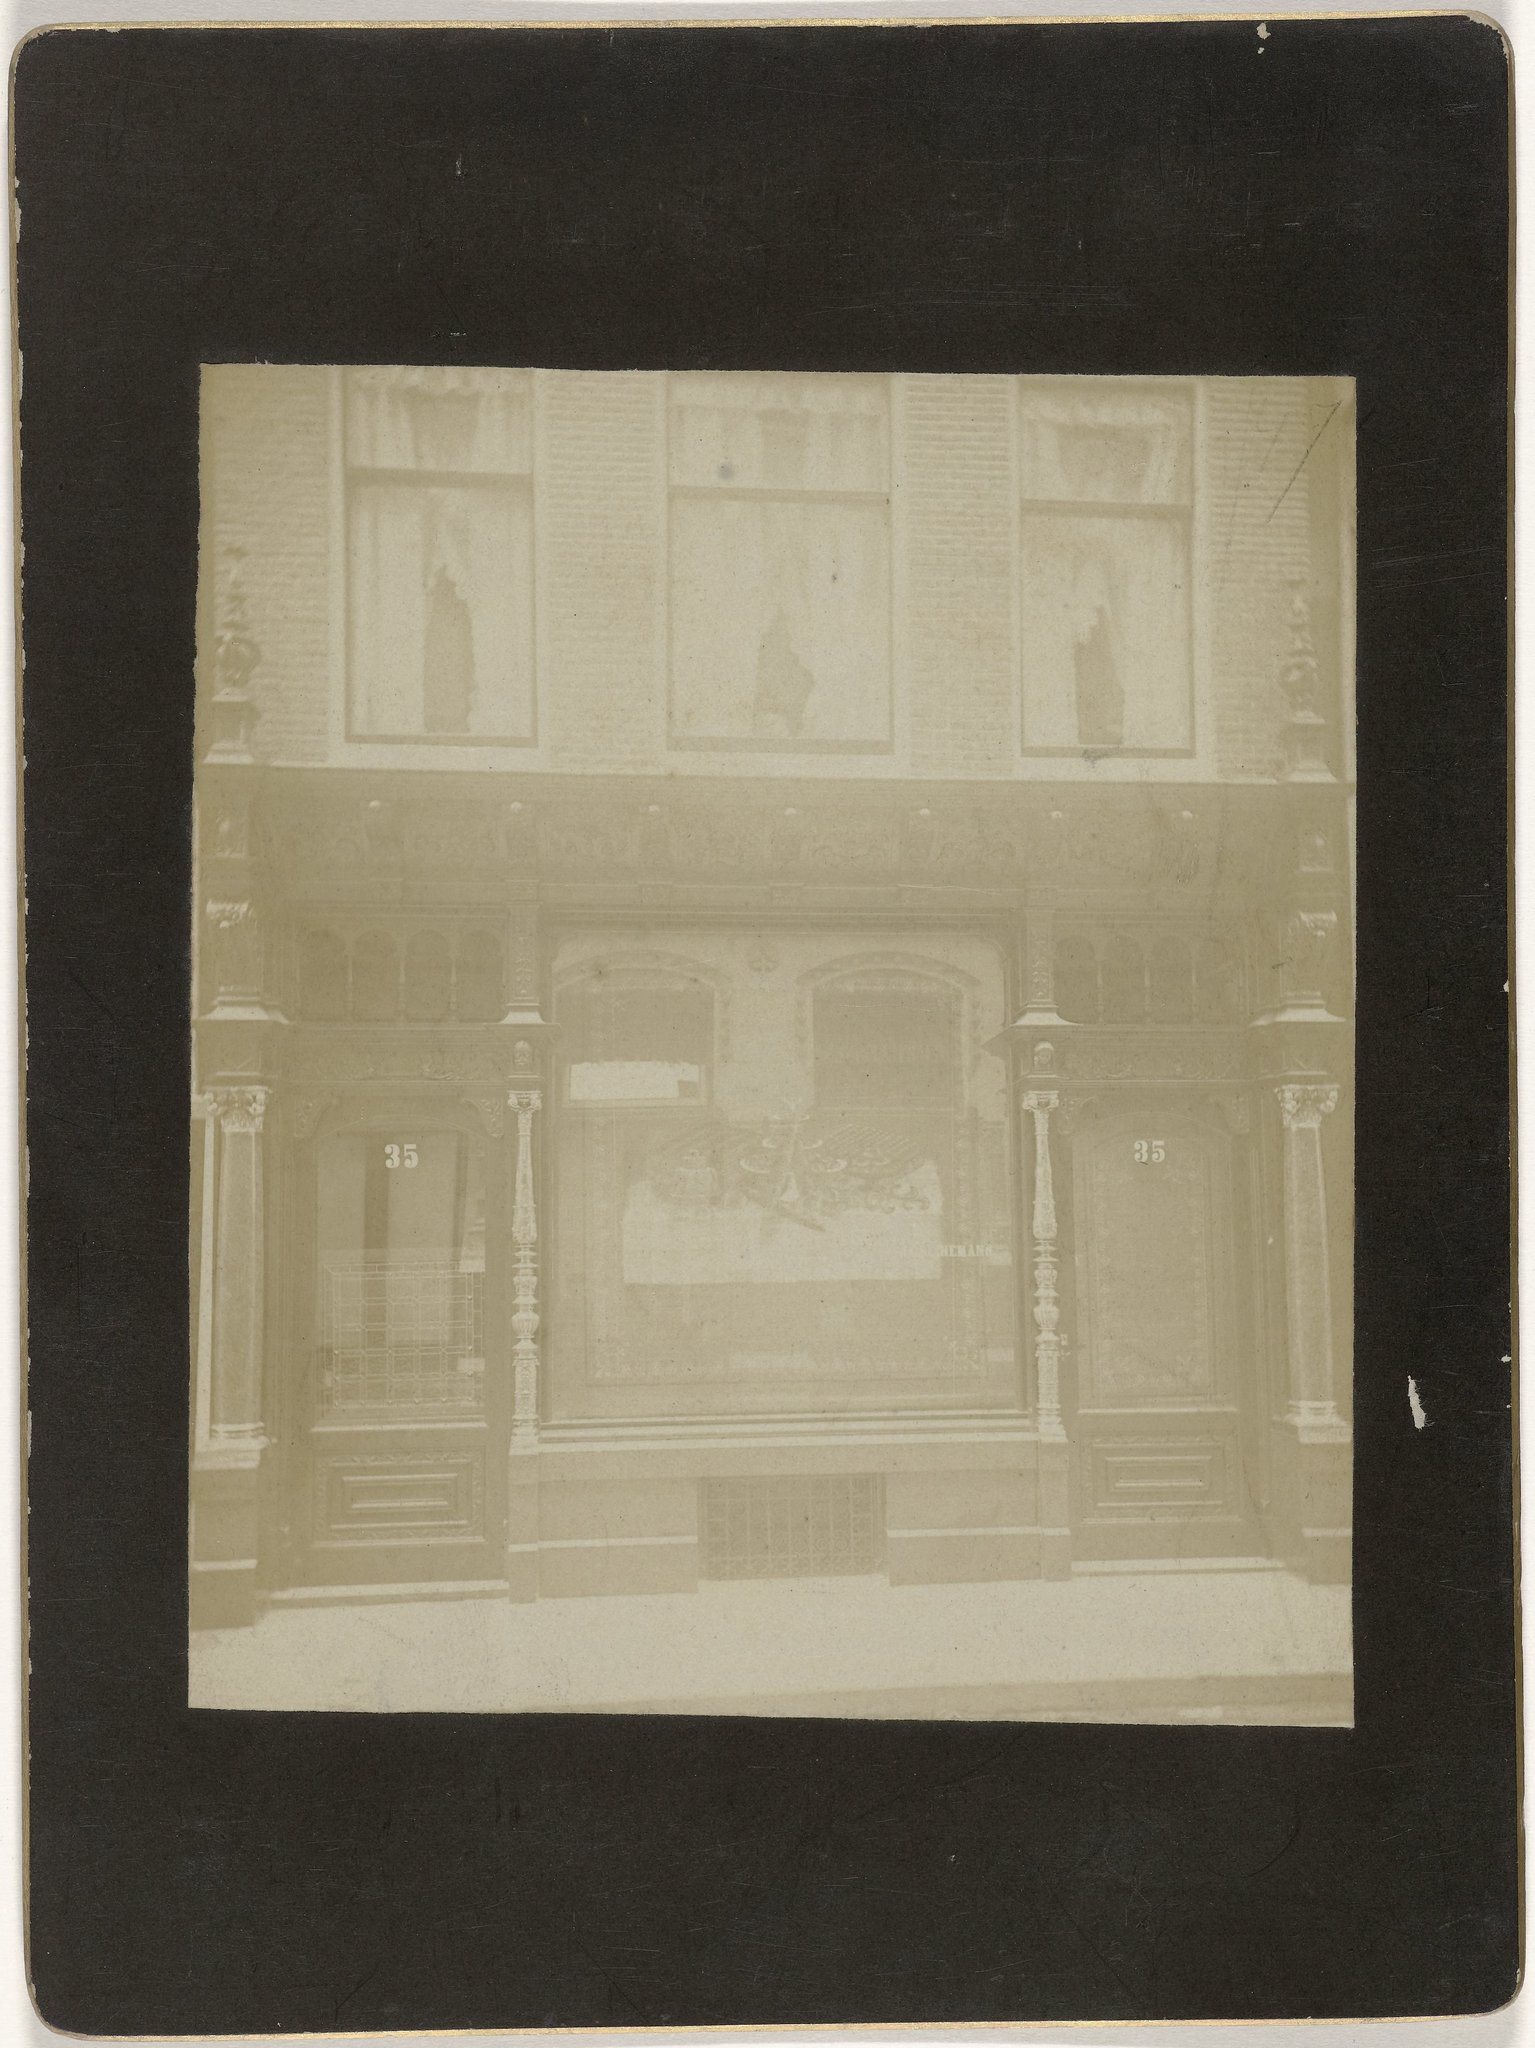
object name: cabinet photograph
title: Heiligeweg 35, Amsterdam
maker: Anonymous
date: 1890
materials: cardboard, paper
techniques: collodion silver print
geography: amsterdam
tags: shop, store